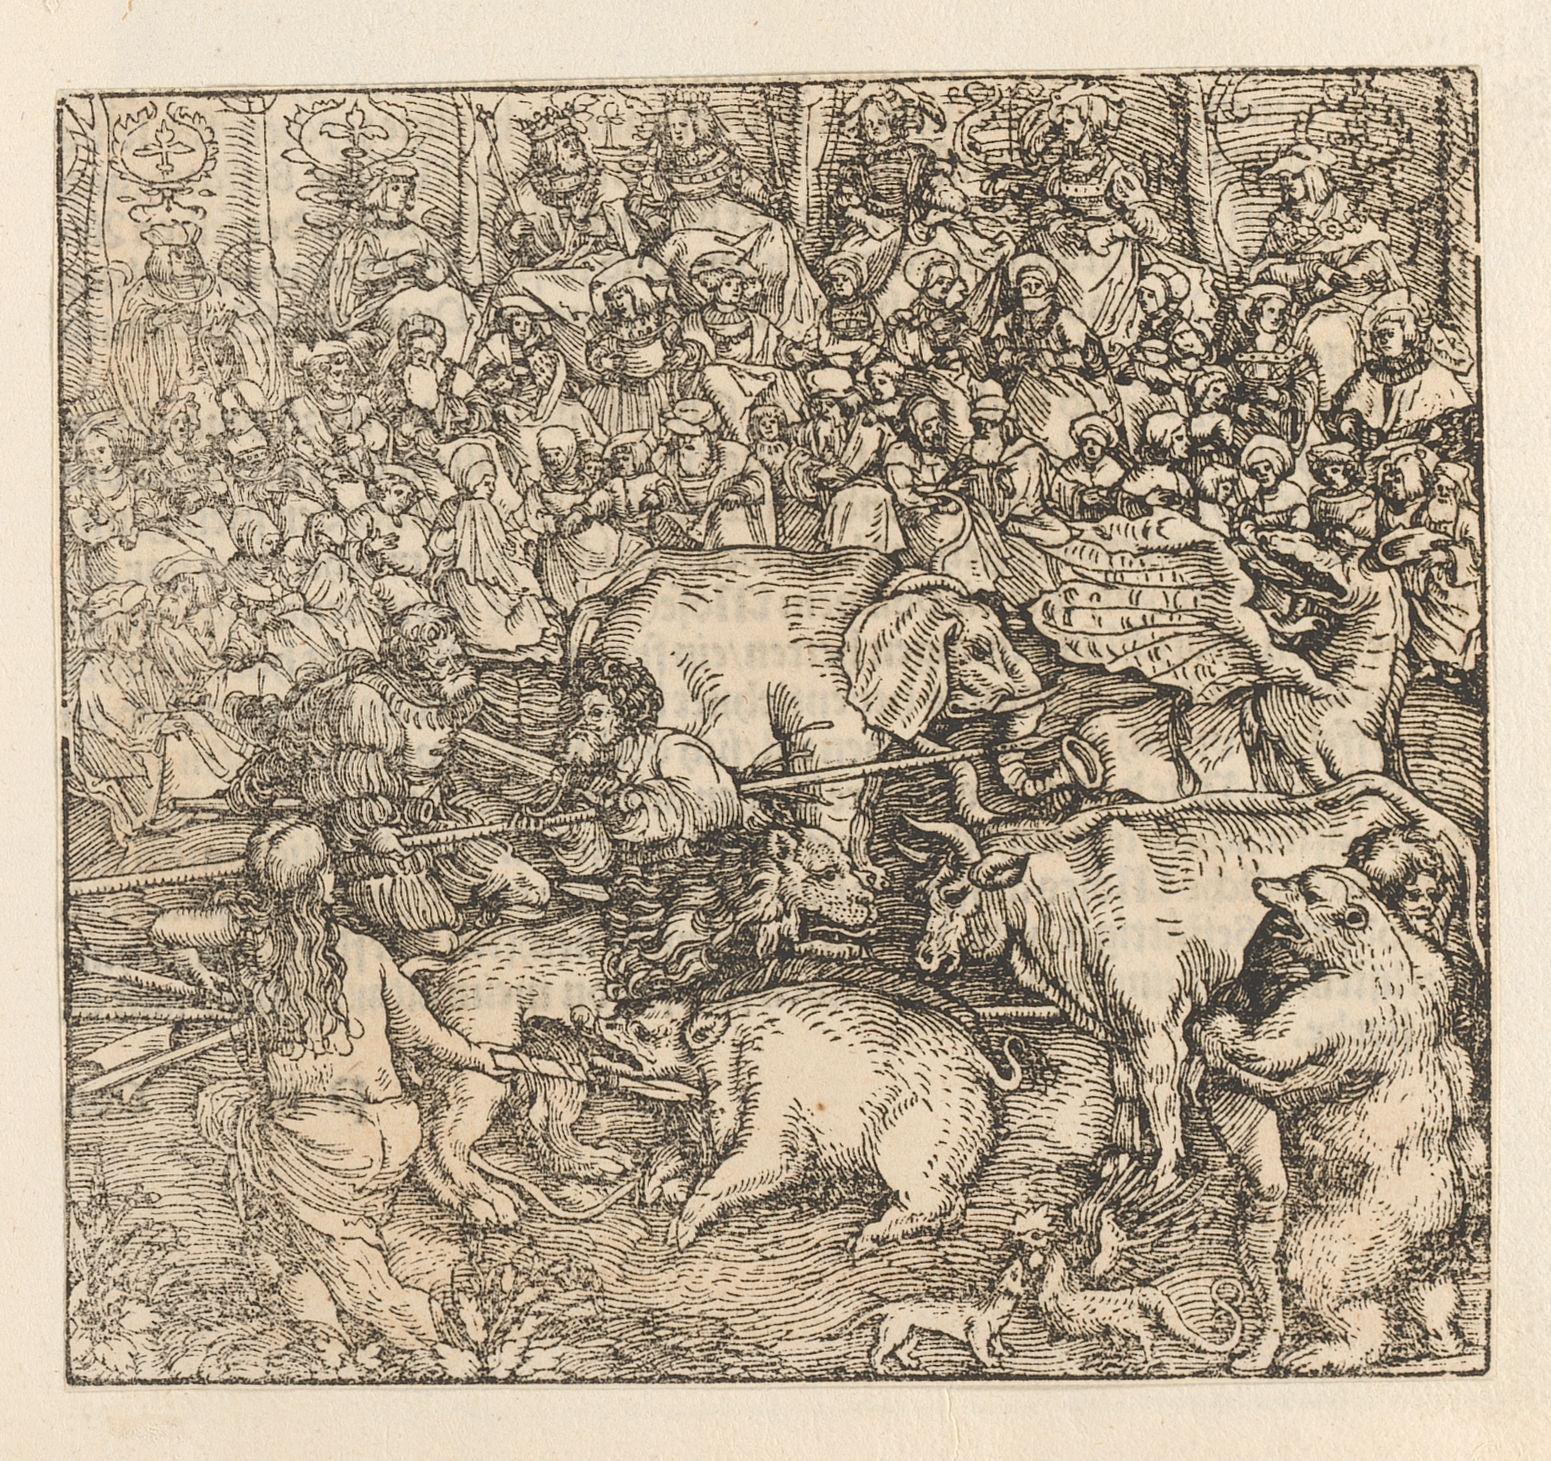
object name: album leaf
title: Circus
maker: Anonymous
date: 1514-1532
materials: paper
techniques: letterpress printing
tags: circus animals, hoofed animals: boar, beasts of prey, predatory animals: bear, circus, dragon, ox, beasts of prey, predatory animals: lion, trunked animals: elephant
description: Deze prent is gebruikt in: Petrarca, Francesco. Von der Artzney bayder Glück, des guten und widerwertigen: unnd weß sich ain yeder inn Gelück und Unglück halten sol (...). Augsburg: Heinrich Steiner, 1532. Deze uitgave is ook bekend onder de titel 'Trostspiegel in Glück und Unglück'.